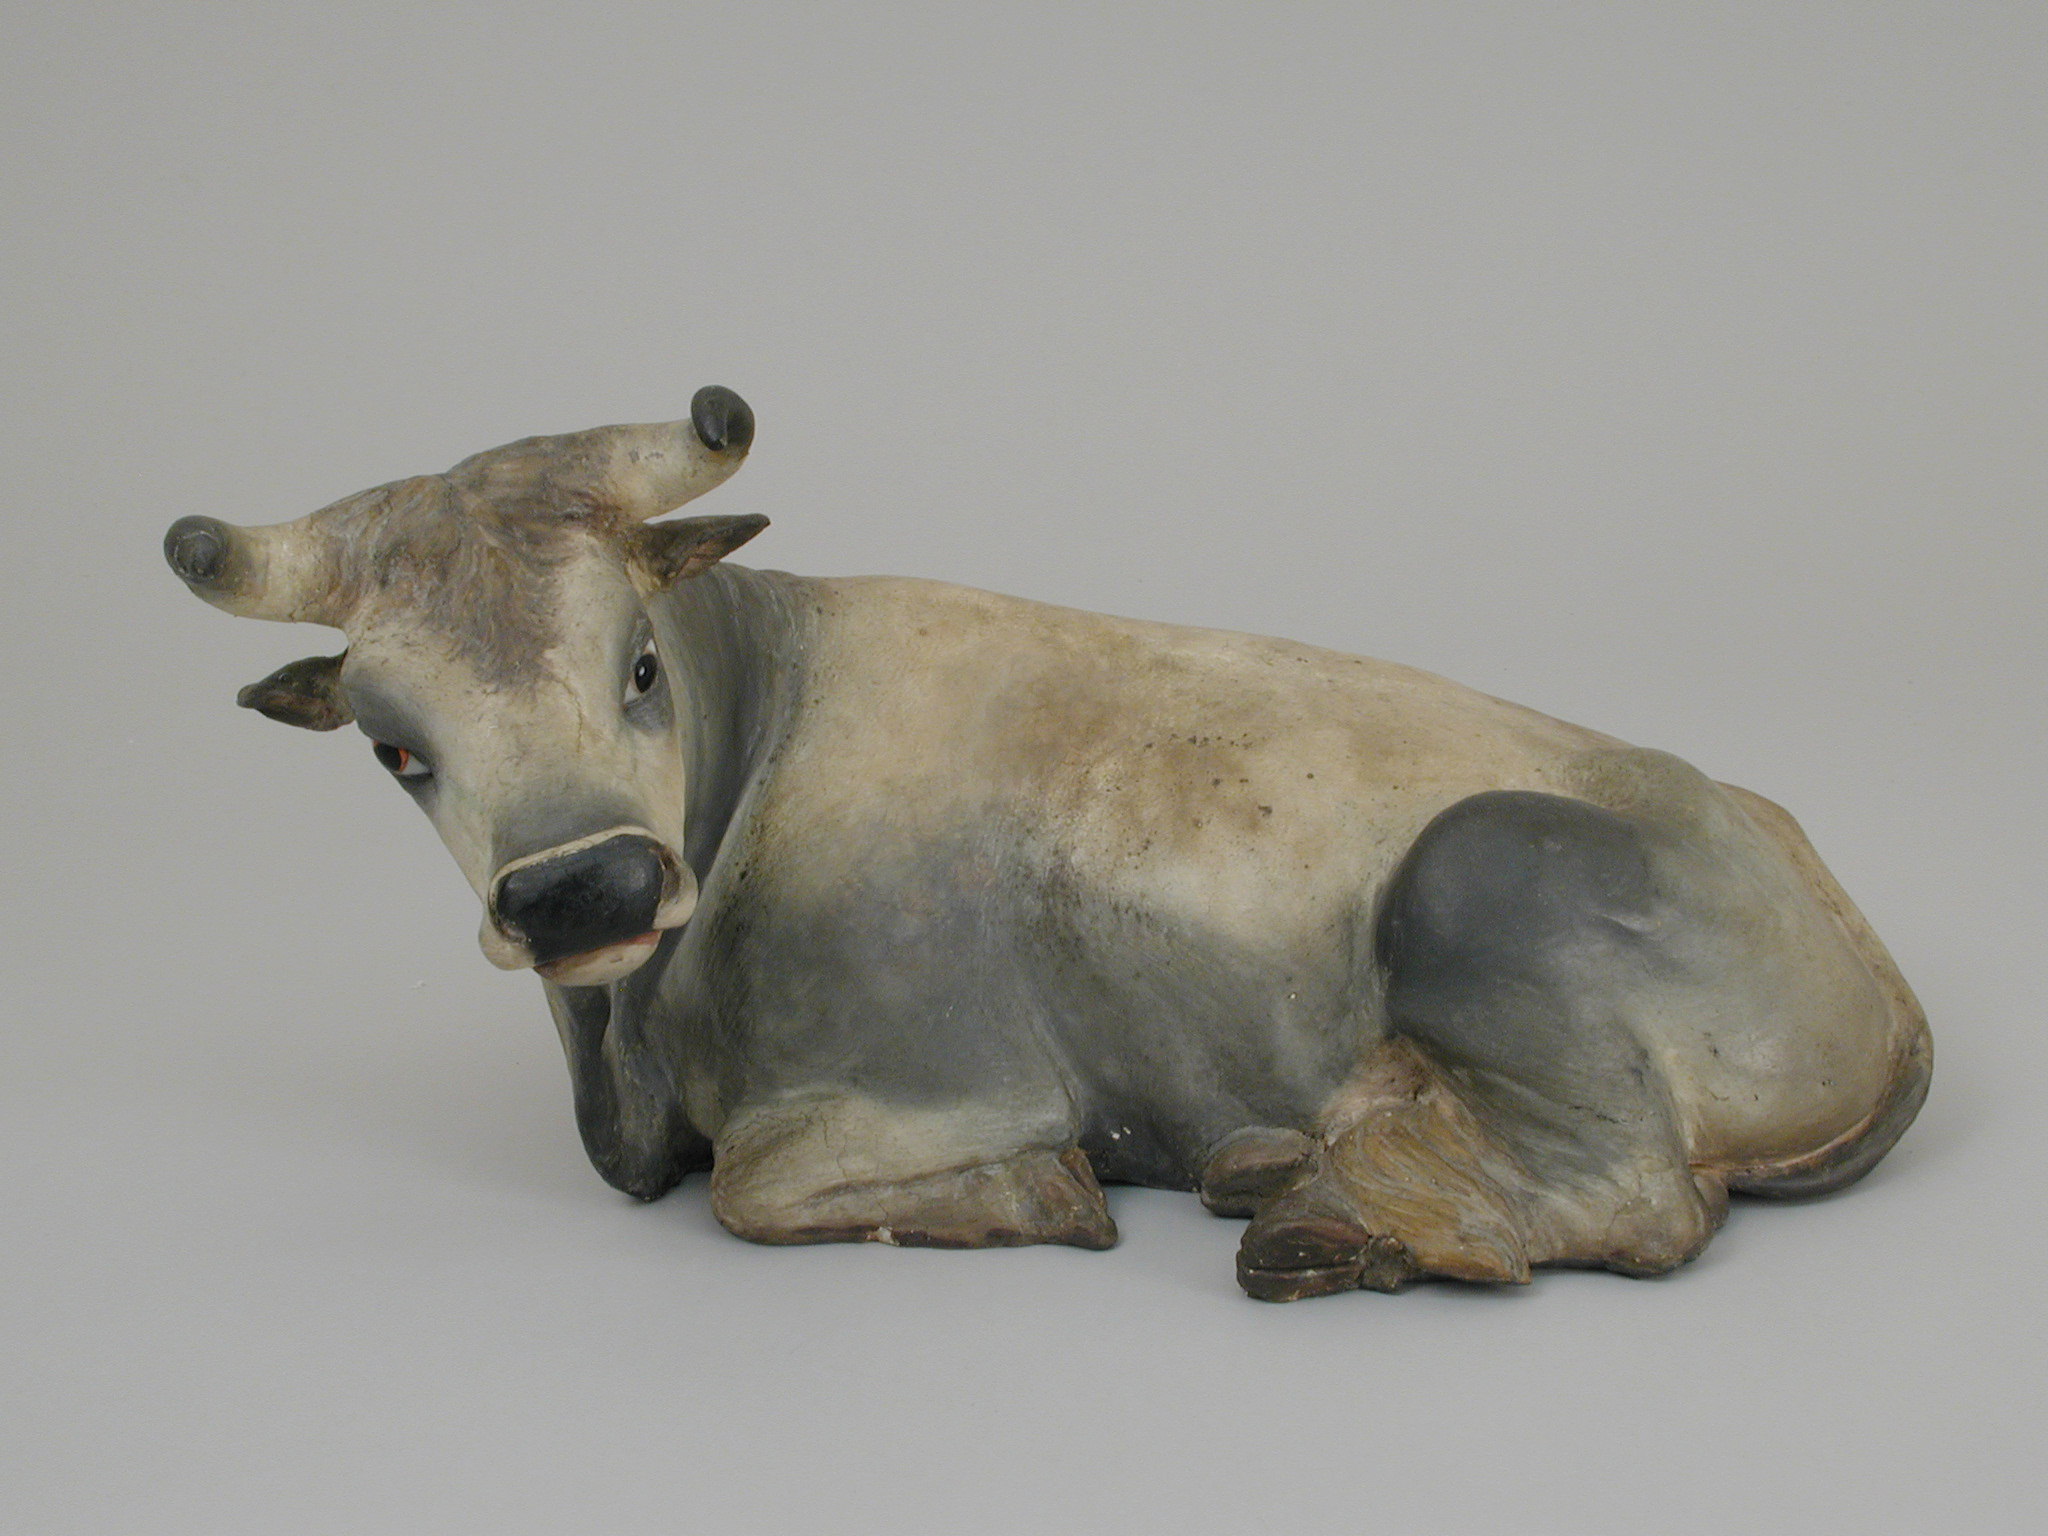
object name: crèche figure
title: Cow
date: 1751-1800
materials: terracotta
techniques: polychrome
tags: cows